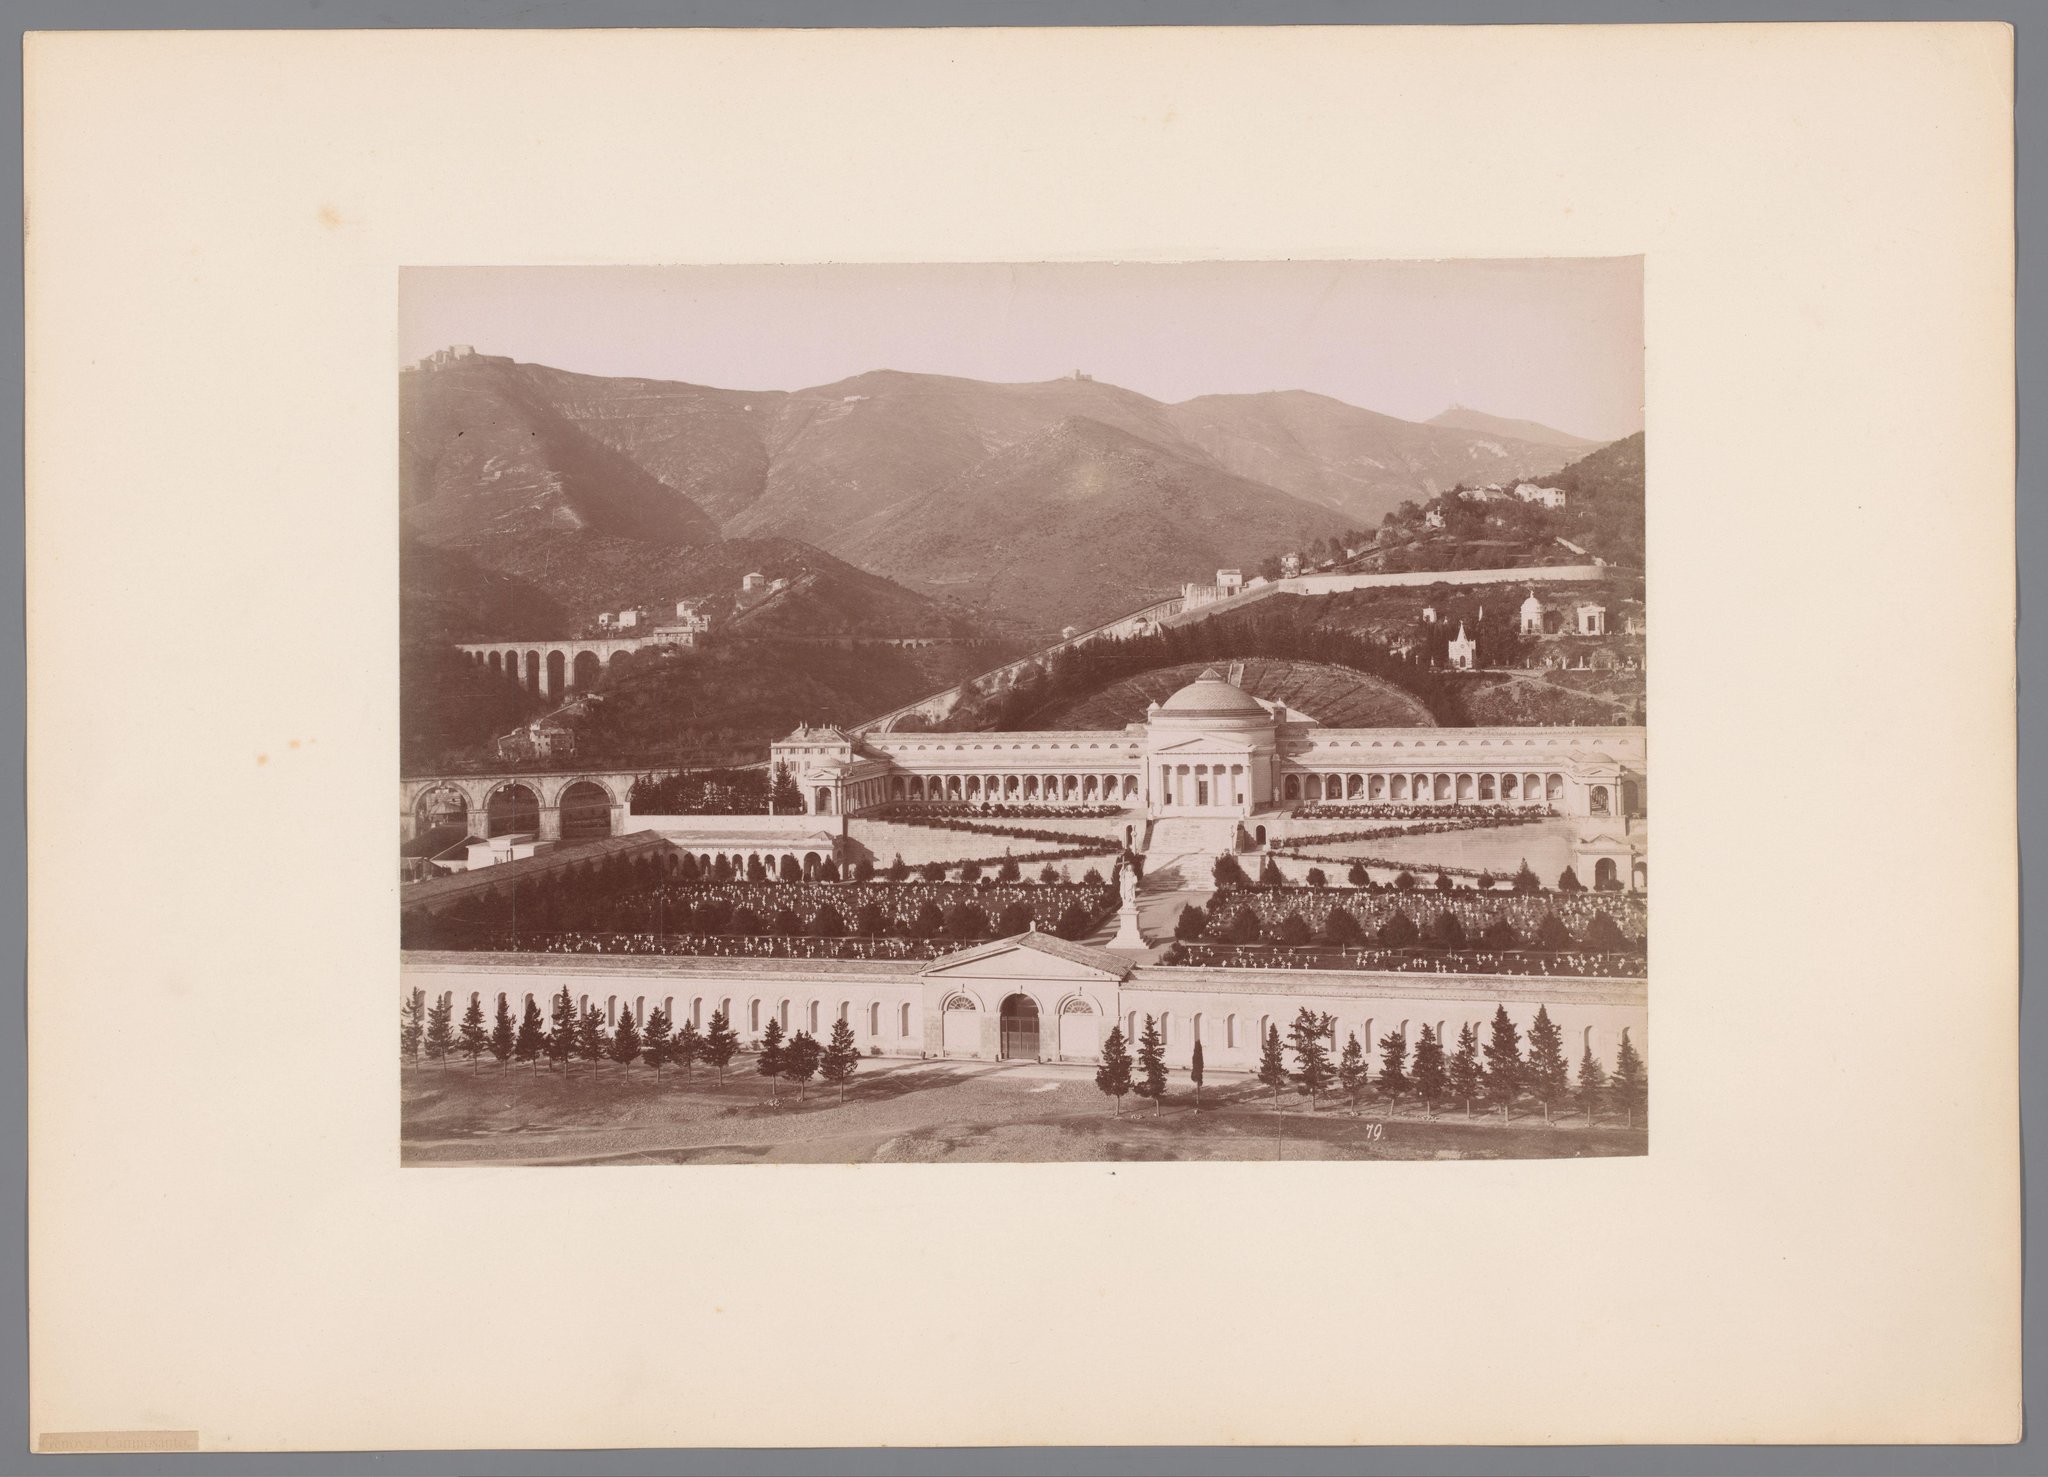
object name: photograph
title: Genova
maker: alfredo noack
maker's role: fotograaf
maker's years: 1833-1895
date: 1858-1893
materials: cardboard, paper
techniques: albumen print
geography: genoa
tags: cemetery, park-like burying ground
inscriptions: inscription: ‘Noack (t)’, number: ‘79.’, number: ‘119.’